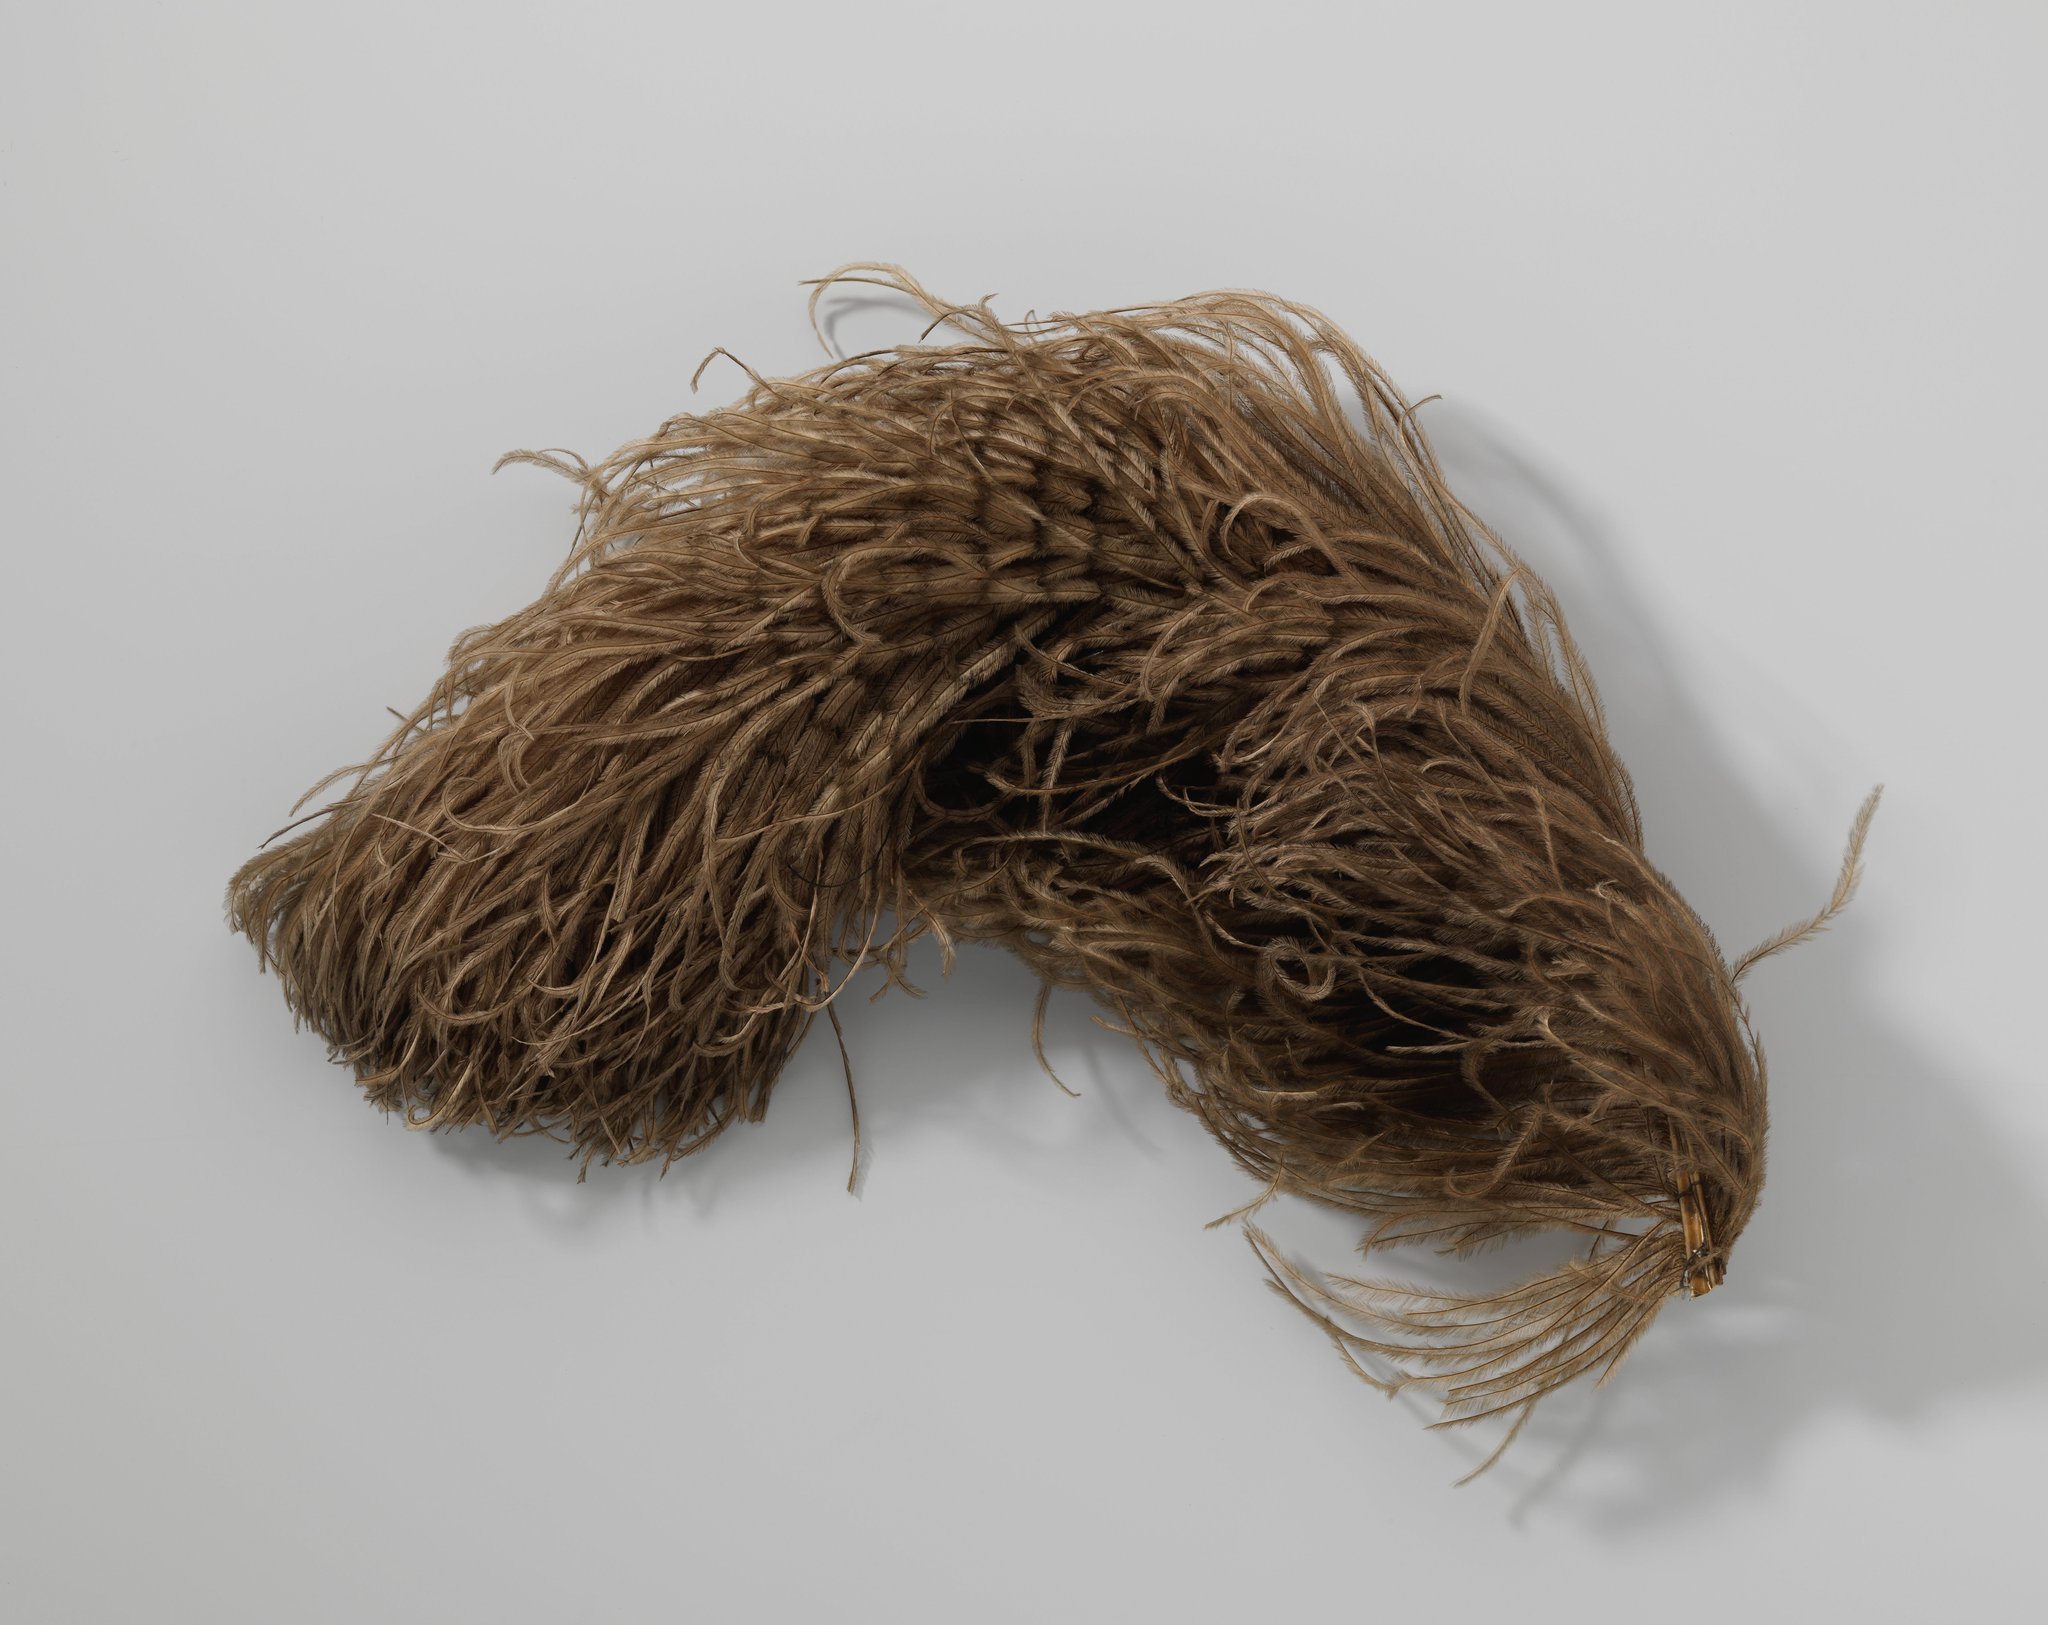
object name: hoedenveer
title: Struisveer, bruin van kleur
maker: Anonymous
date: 1895-1915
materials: ostrich feather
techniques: painting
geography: western europe